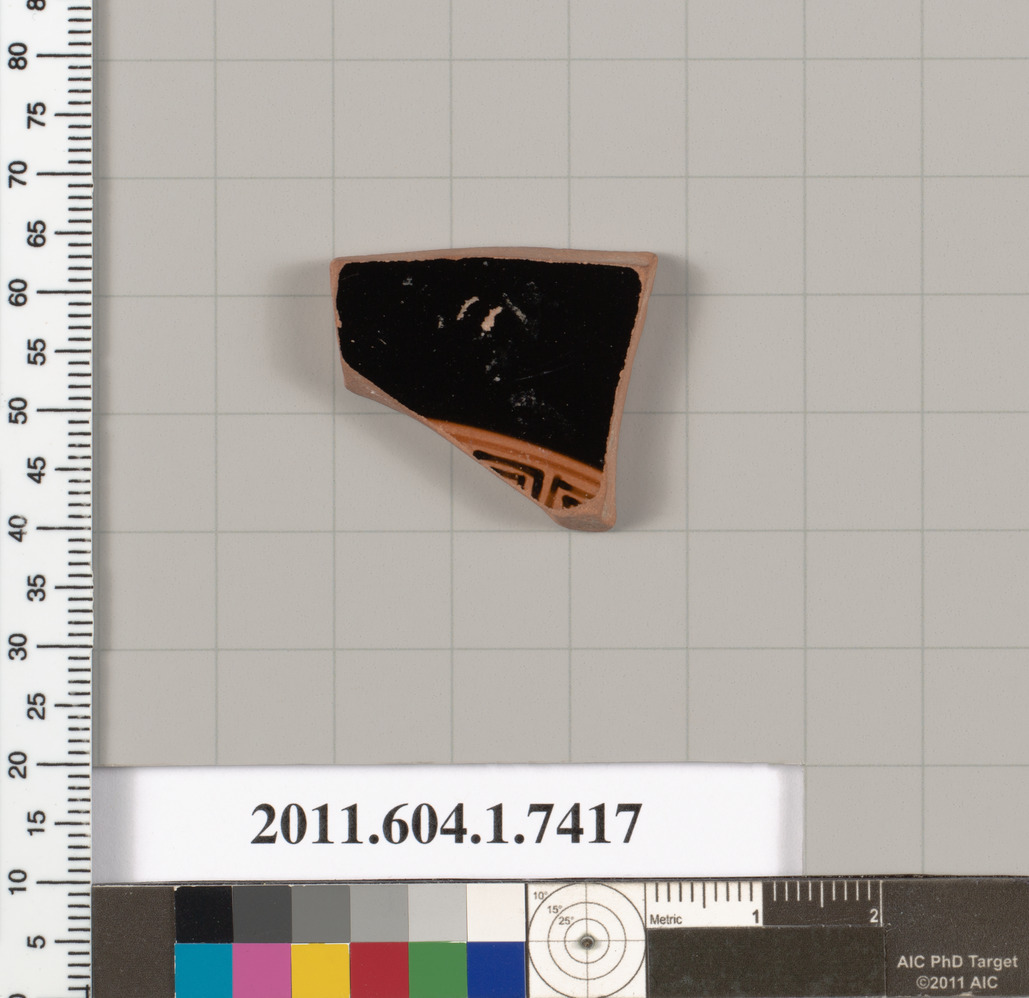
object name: kylix fragment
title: Terracotta fragment of a kylix (drinking cup)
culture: greek, attic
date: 490-470 BCE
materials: terracotta